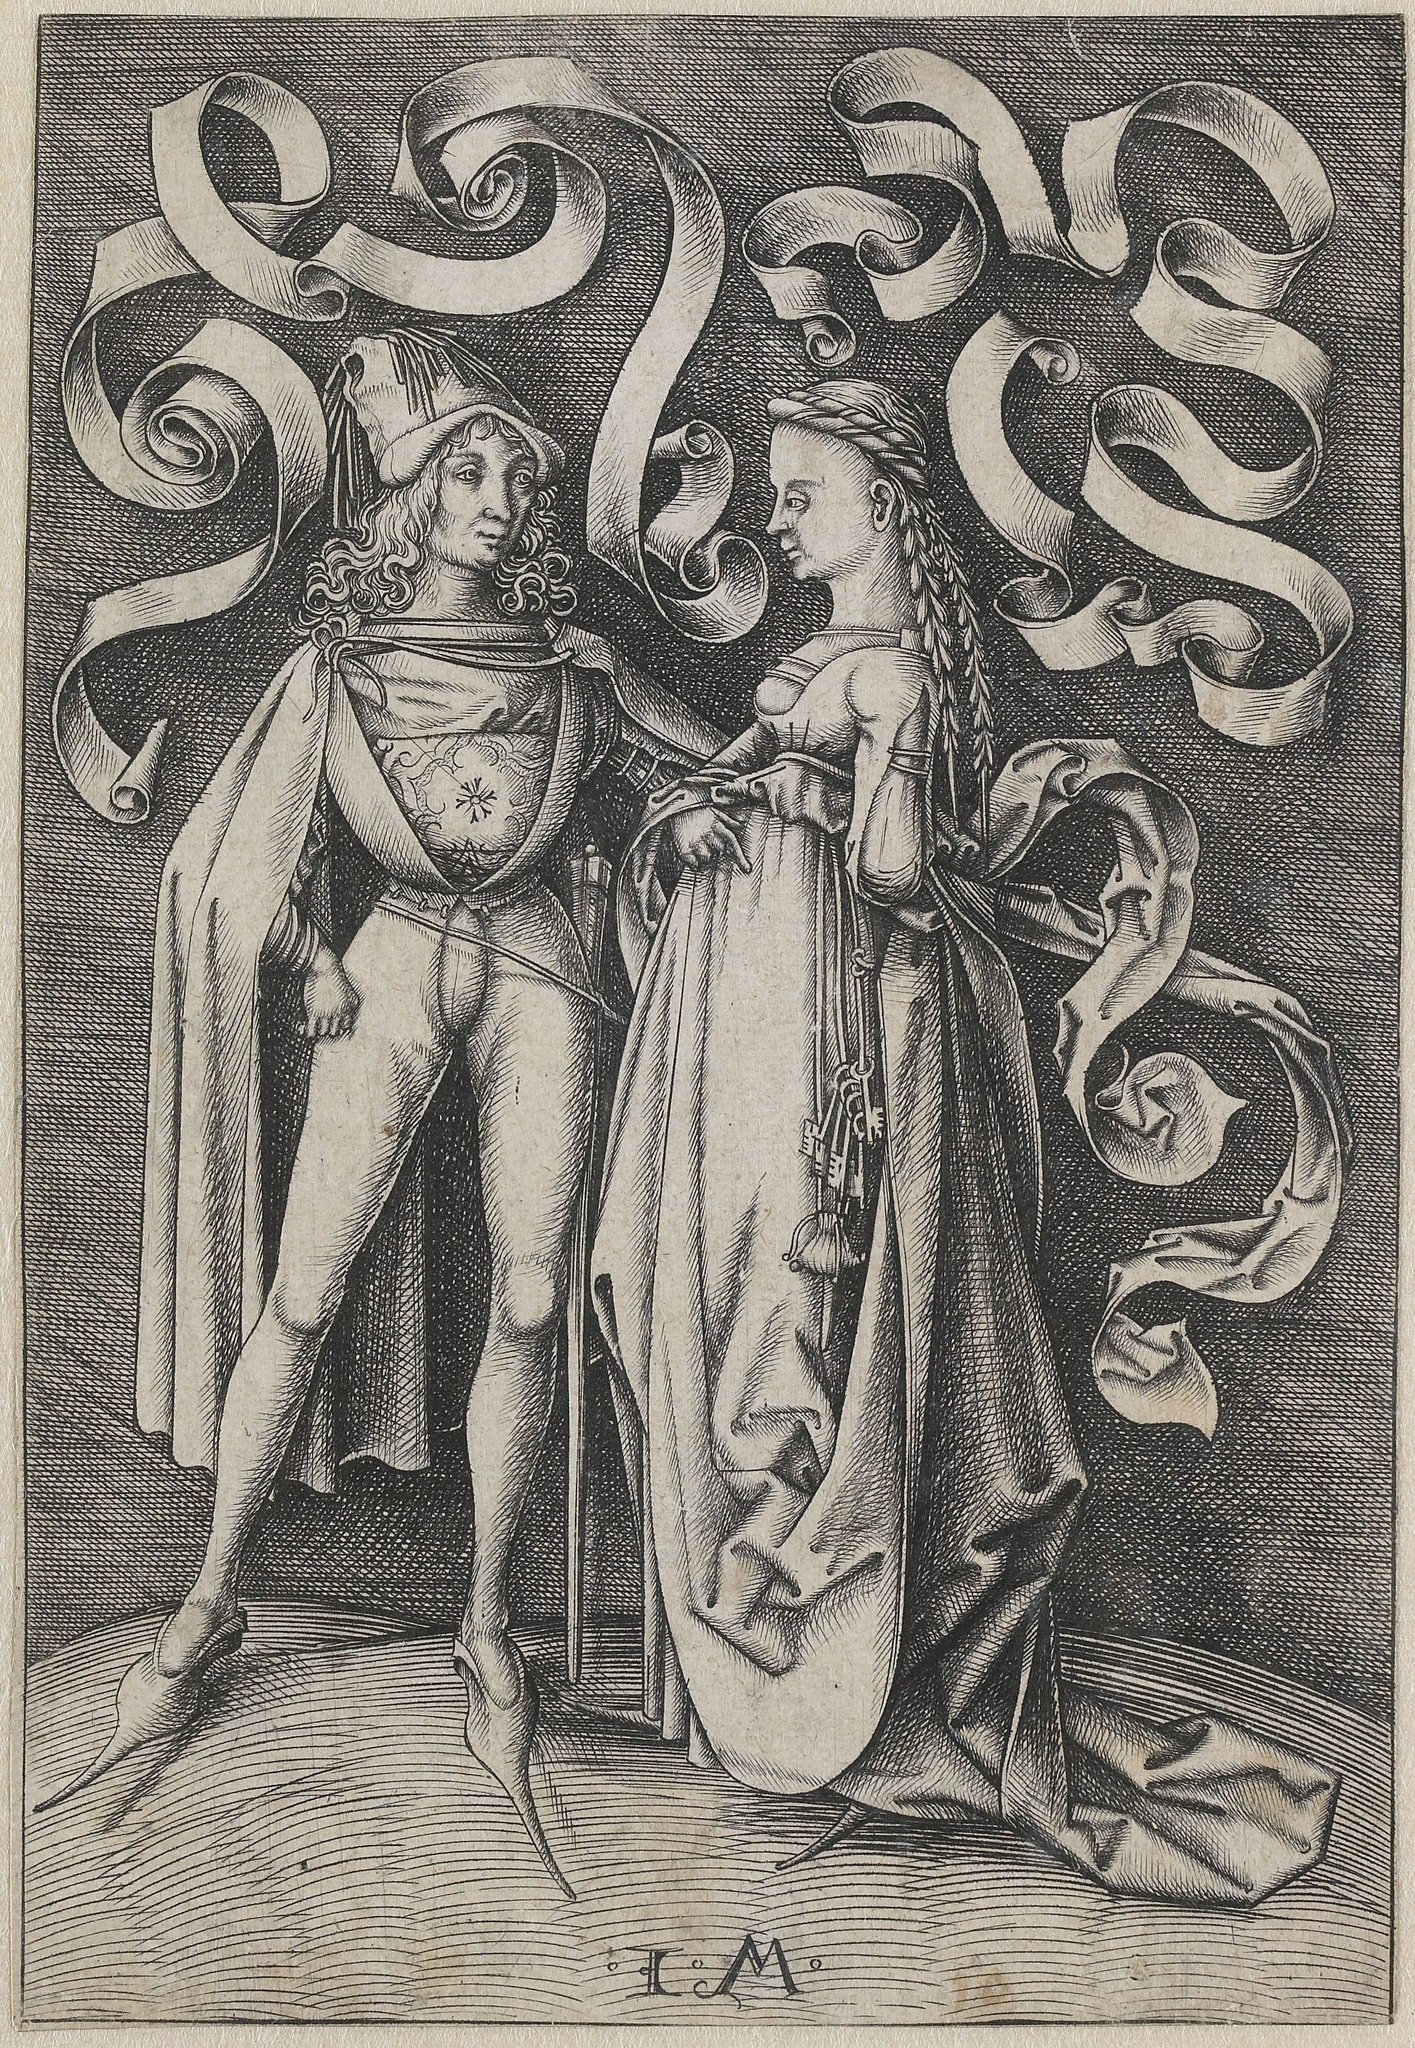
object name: print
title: Ridder en een dame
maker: israhel van meckenem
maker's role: print maker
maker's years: 1440-1517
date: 1490-1503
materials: paper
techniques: engraving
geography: bocholt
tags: purse, money-bag, cape (+ men's clothes), styles of hairdress (with name) - aa - ~ women, other clothing accessories (keys) (+ women's clothes), other clothing accessories (purse) (+ women's clothes), codpiece (cover for the genitals), head-gear: hat (+ men's clothes), clothes, costume (+ women's clothes), key ~ furniture, dress, gown (+ women's clothes), clothes, costume (+ men's clothes), shoes, sandals, trousers, breeches, etc. (breeches) (+ men's clothes), nobility and patriciate; chivalry, knighthood, belt, girdle, waistband (+ women's clothes)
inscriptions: collector's mark: Lugt 2760, collector's mark: Lugt 2228, collector's mark: ‘IP’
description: Kleding man: cape over een wambuis en hozen; aan zijn voeten puntschoenen. Kleding vrouw: ceintuur met sleutelbos en een beurs. Ihle p. 7, 11B: paar in typisch Duitse dracht uit eind 15de eeuw. Kenmerkend hiervoor. Man: wambuis met diepe uitsnijding tot de taille, dat is gevuld met borstlap, waarboven hemd (?) te voorschijn komt. Zichtbare schaambuidel die in de mode van volgende eeuw prominente plaats krijgt. Wambuis is duidelijk met veters aan de hozen bevestigd, zodat bukken om=nmogelijk is. Mantel op de schouders bevestigd. Hoge muts op het lange haar. Tootschoenen. Vrouw: knopvormige vlechten. Opgeschorte japon met lage hals en gespleten mouwen. Bos sleutels aan ceintuur. (vrouw van gewicht)